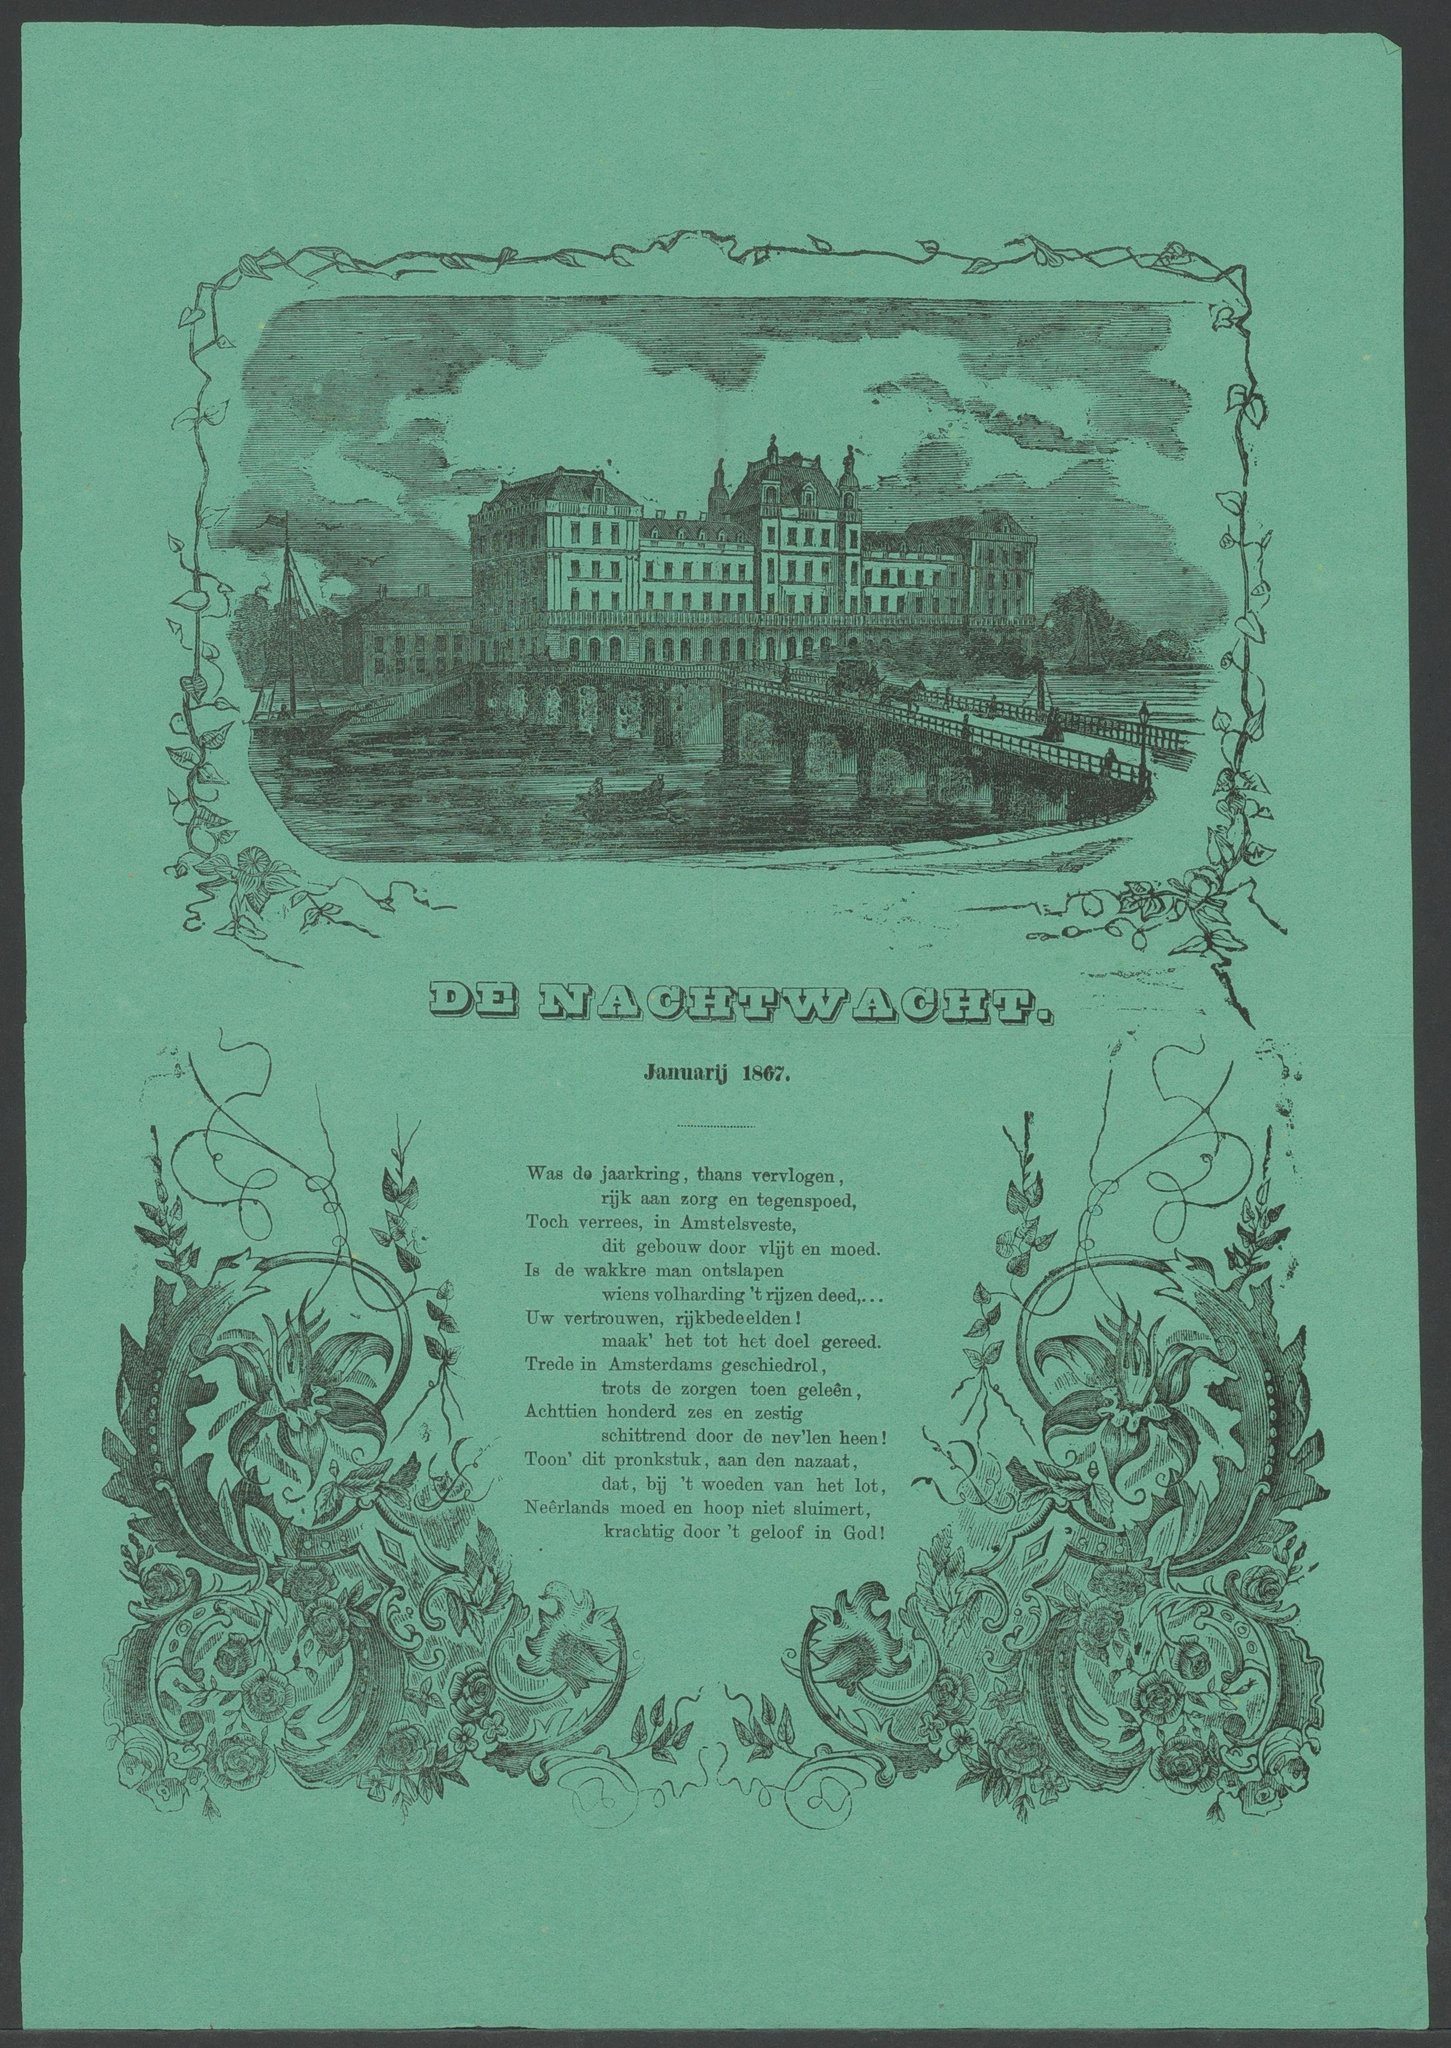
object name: print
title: De Nachtwacht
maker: Anonymous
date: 1866-1867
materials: paper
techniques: letterpress printing, engraving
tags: night patrol, hotel, hostelry, inn, amsterdam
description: Nieuwjaarswens van de Amsterdamse nachtwacht (ratelwacht) voor het jaar 1867. Onderaan een gedicht, bovenaan een gezicht op het Amstelhotel. Onderwerpsrubrieken binnen de Atlas Zeden en Gewoonten: Zeden en gewoonten in engeren zin, Volksleven, Volksbladen, Nieuwjaars- en Kerstwenschen, Amsterdam.